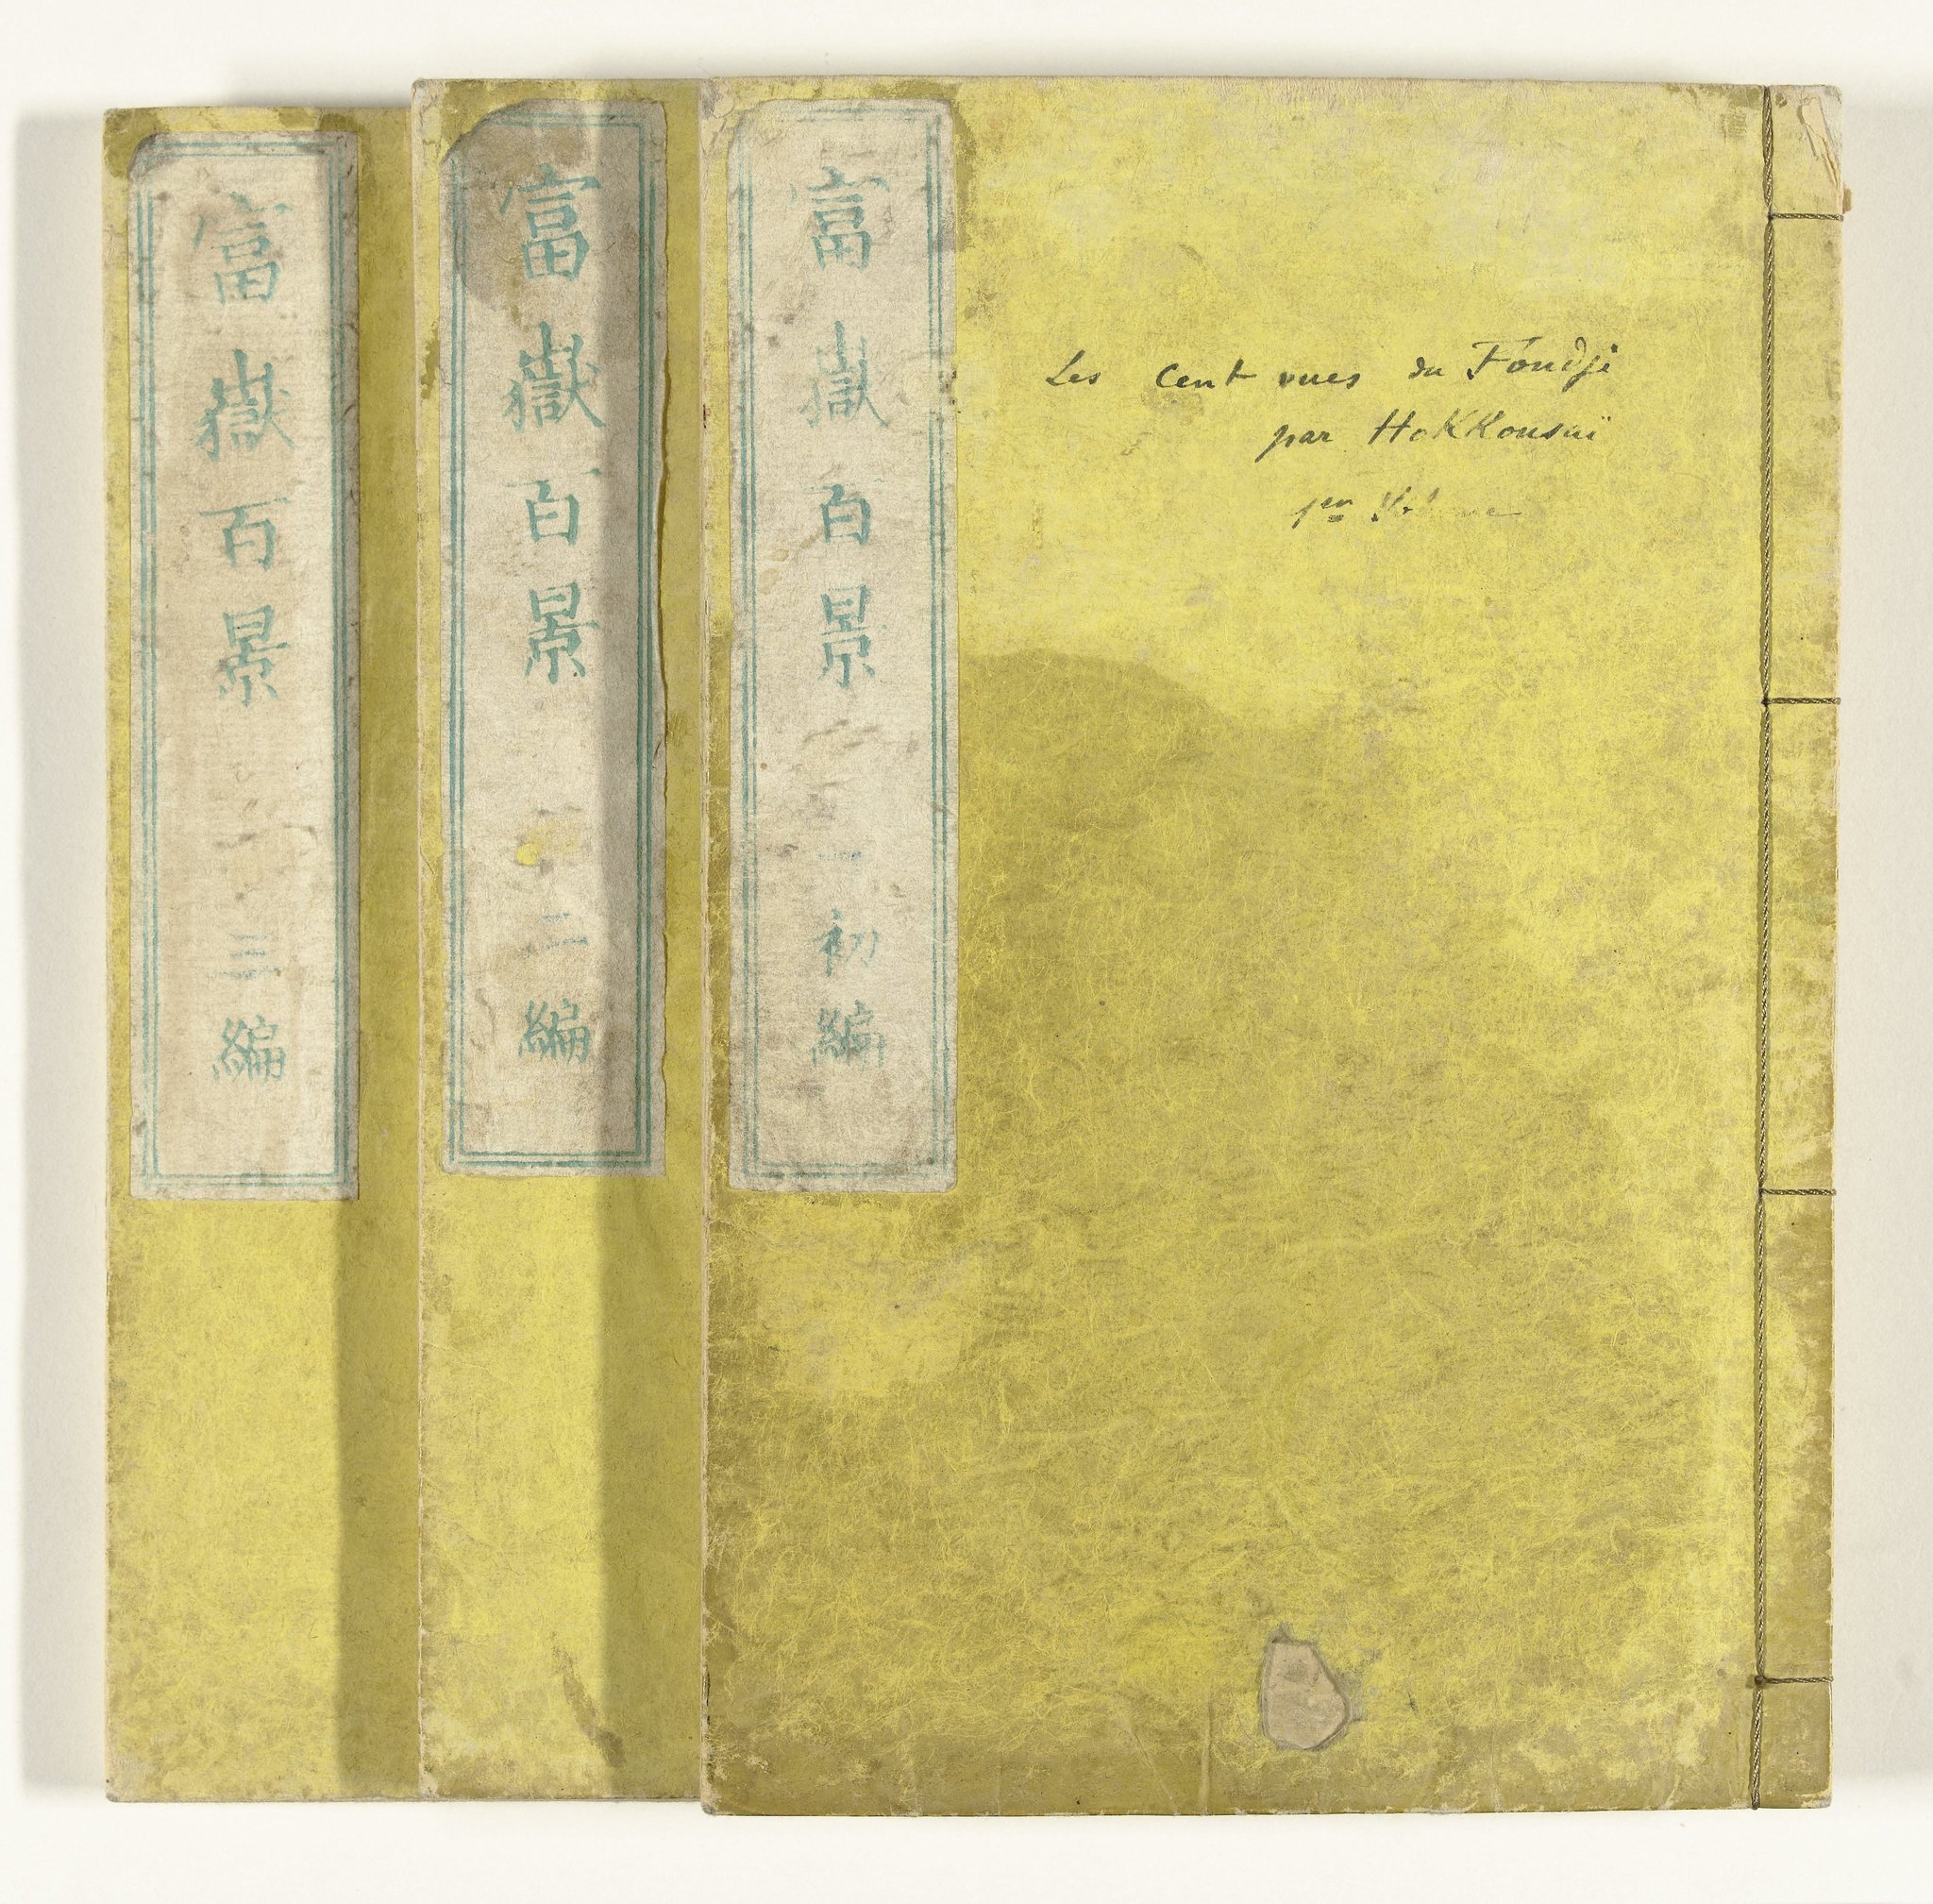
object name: book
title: Fugaku hyakkei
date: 1876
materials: paper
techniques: woodcut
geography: japan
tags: fuji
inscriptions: date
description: Drie delen (compleet) met zwart-wit afbeeldingen van de berg Fuji en omgeving; bewaard in rode chitsu (uitklapbaar doosje). Meiji herdruk.